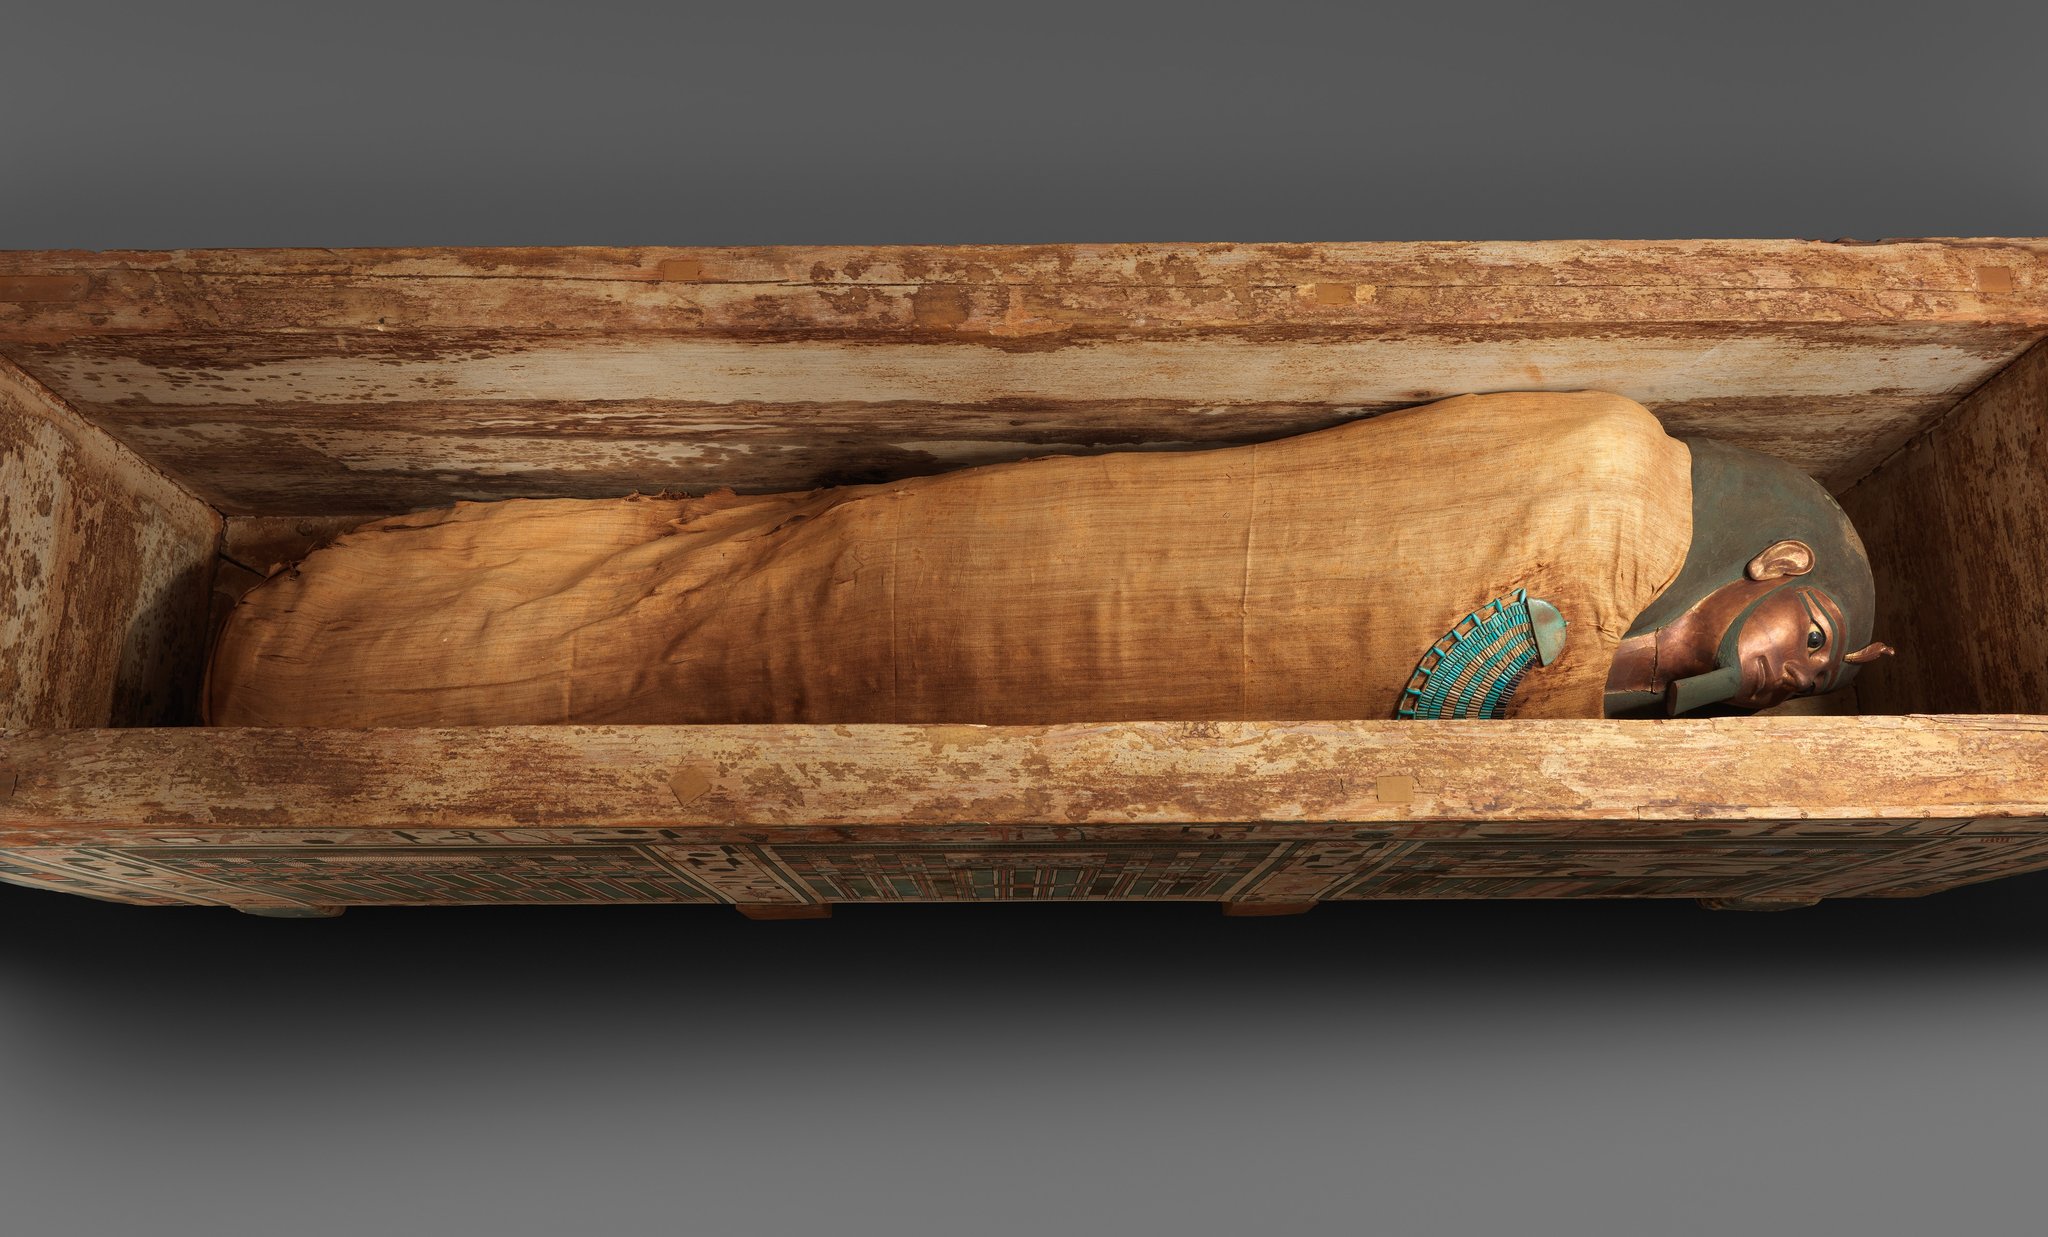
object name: mummy and mask, khnumhotep, human remains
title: Mummy of Khnumhotep with mask and broad collar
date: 1981-1802 BCE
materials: wood, faience, linen, obsidian, stone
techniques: gilding, painting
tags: masks,mummies,sarcophagus